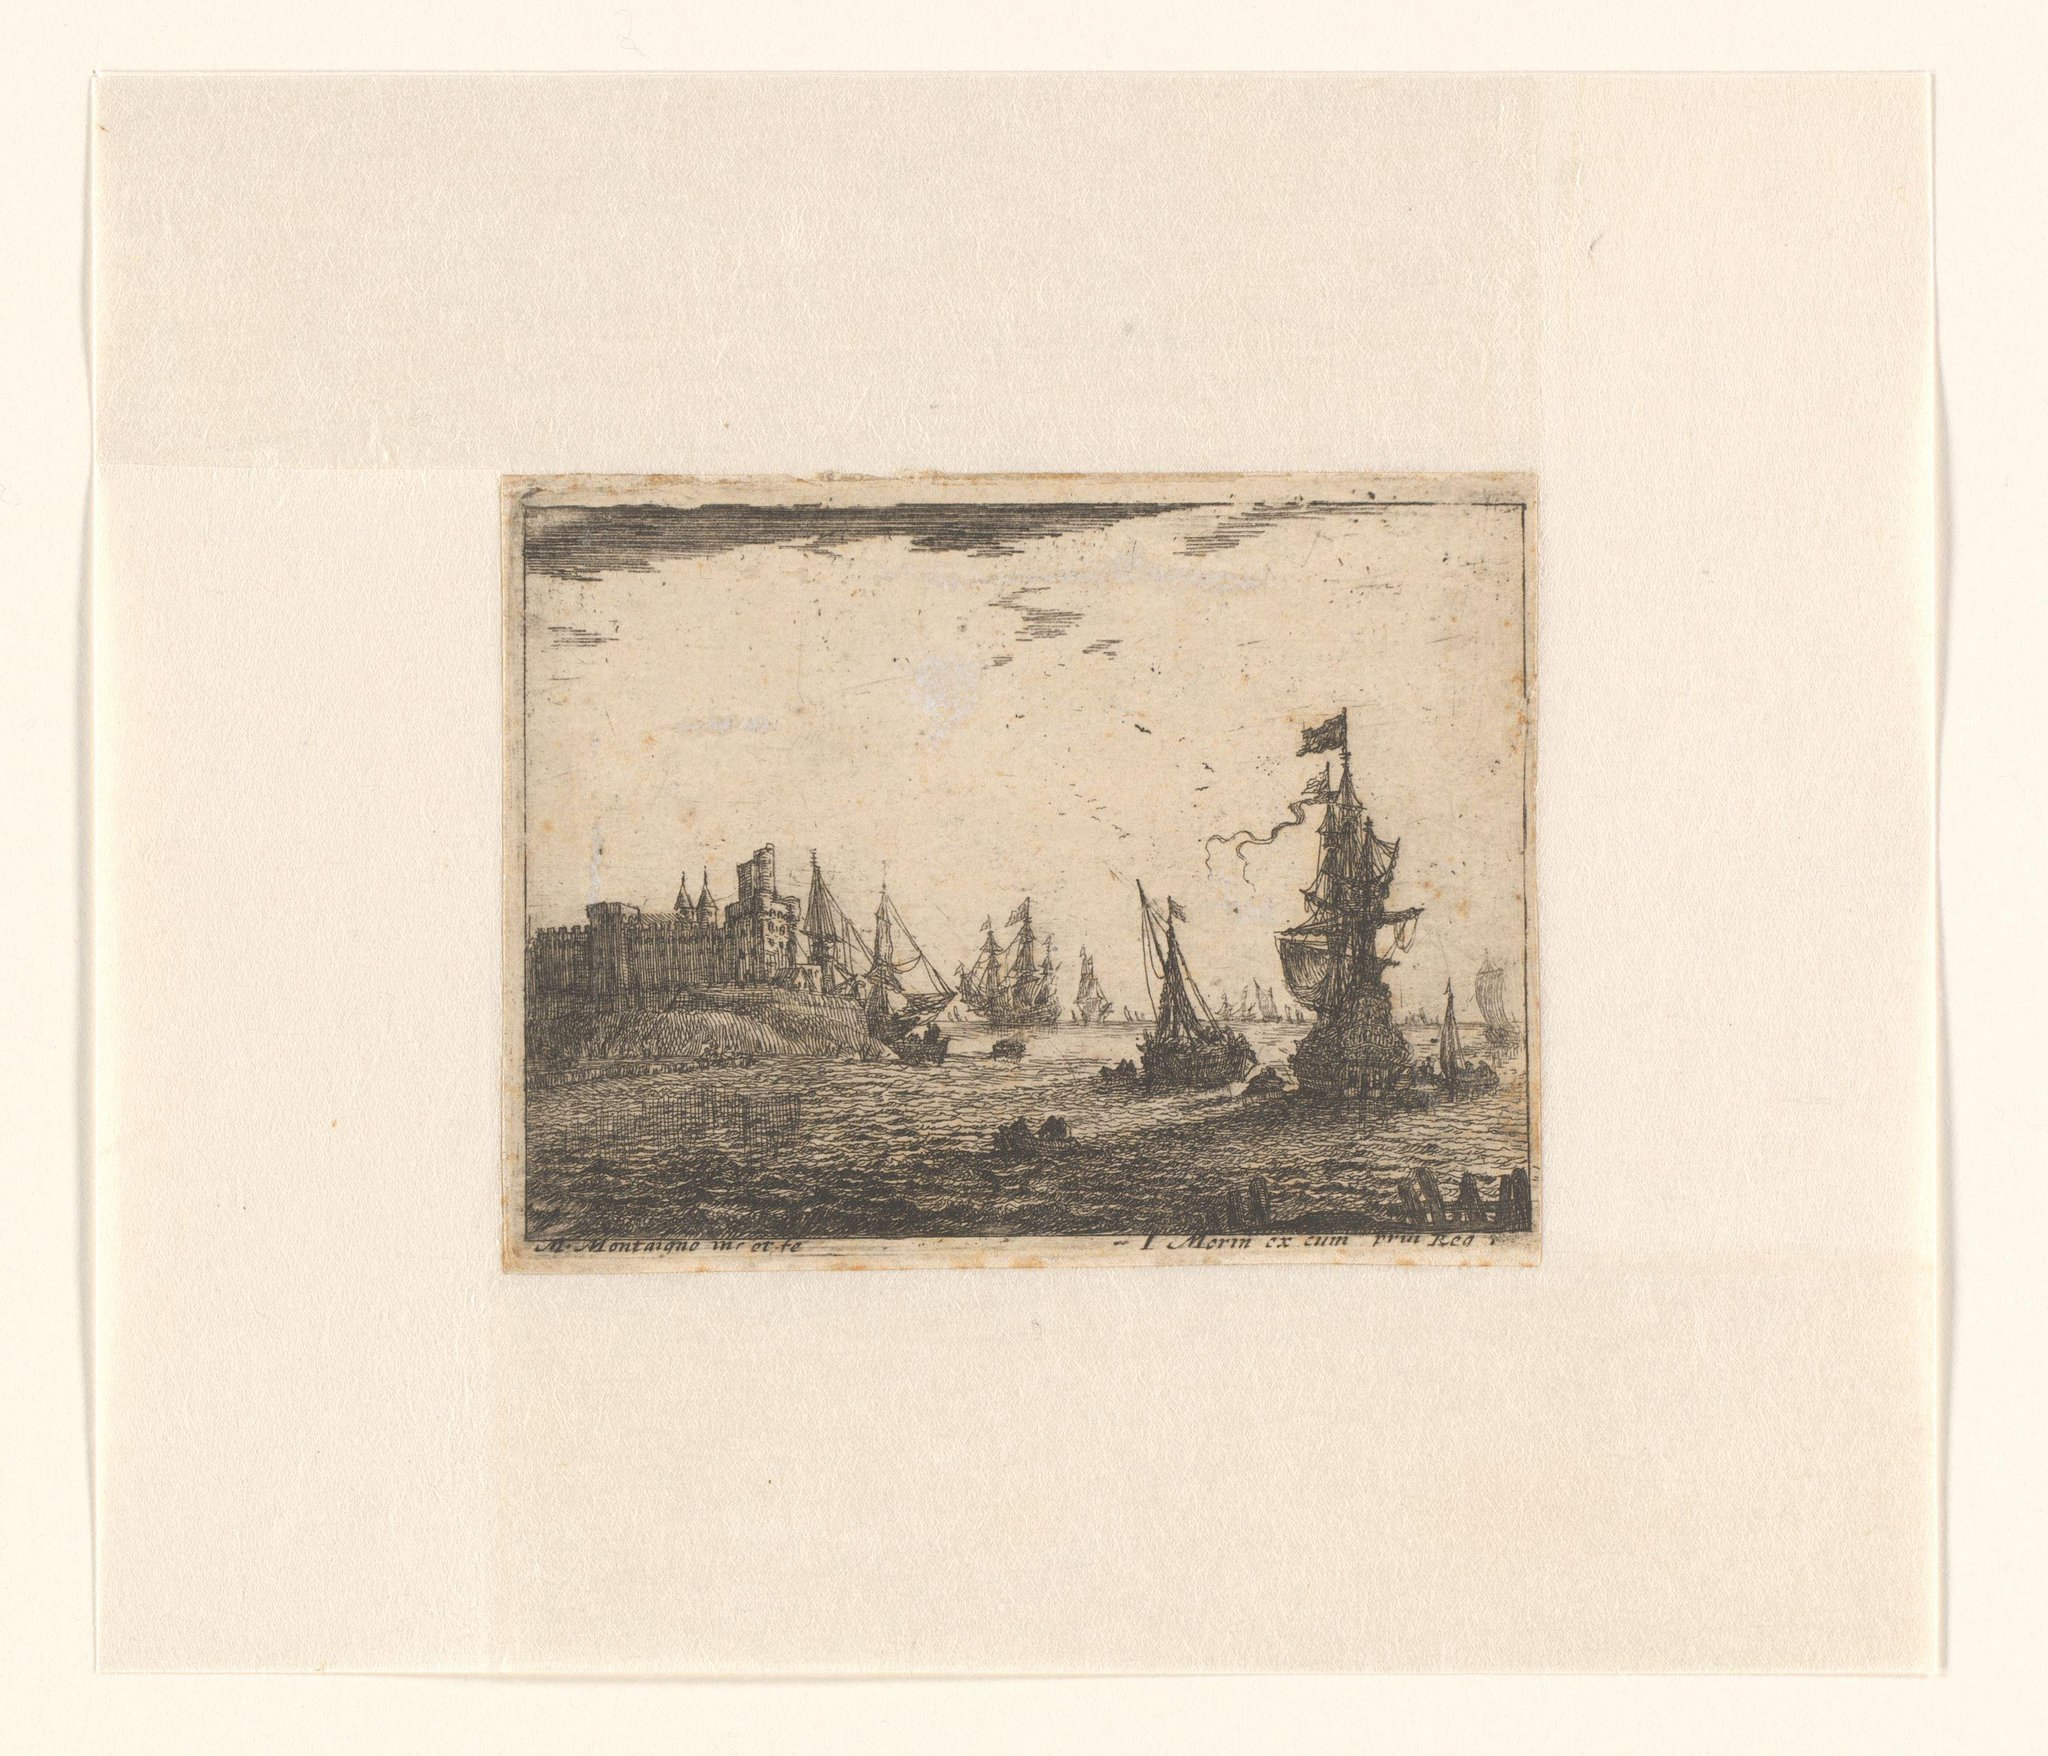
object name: print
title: Zeehaven met schepen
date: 1625-1650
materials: paper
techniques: etching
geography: paris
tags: harbour, fortress, sailing-ship, sailing-boat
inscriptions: inscription: ‘TX-MY’, collector's mark: Lugt 2498